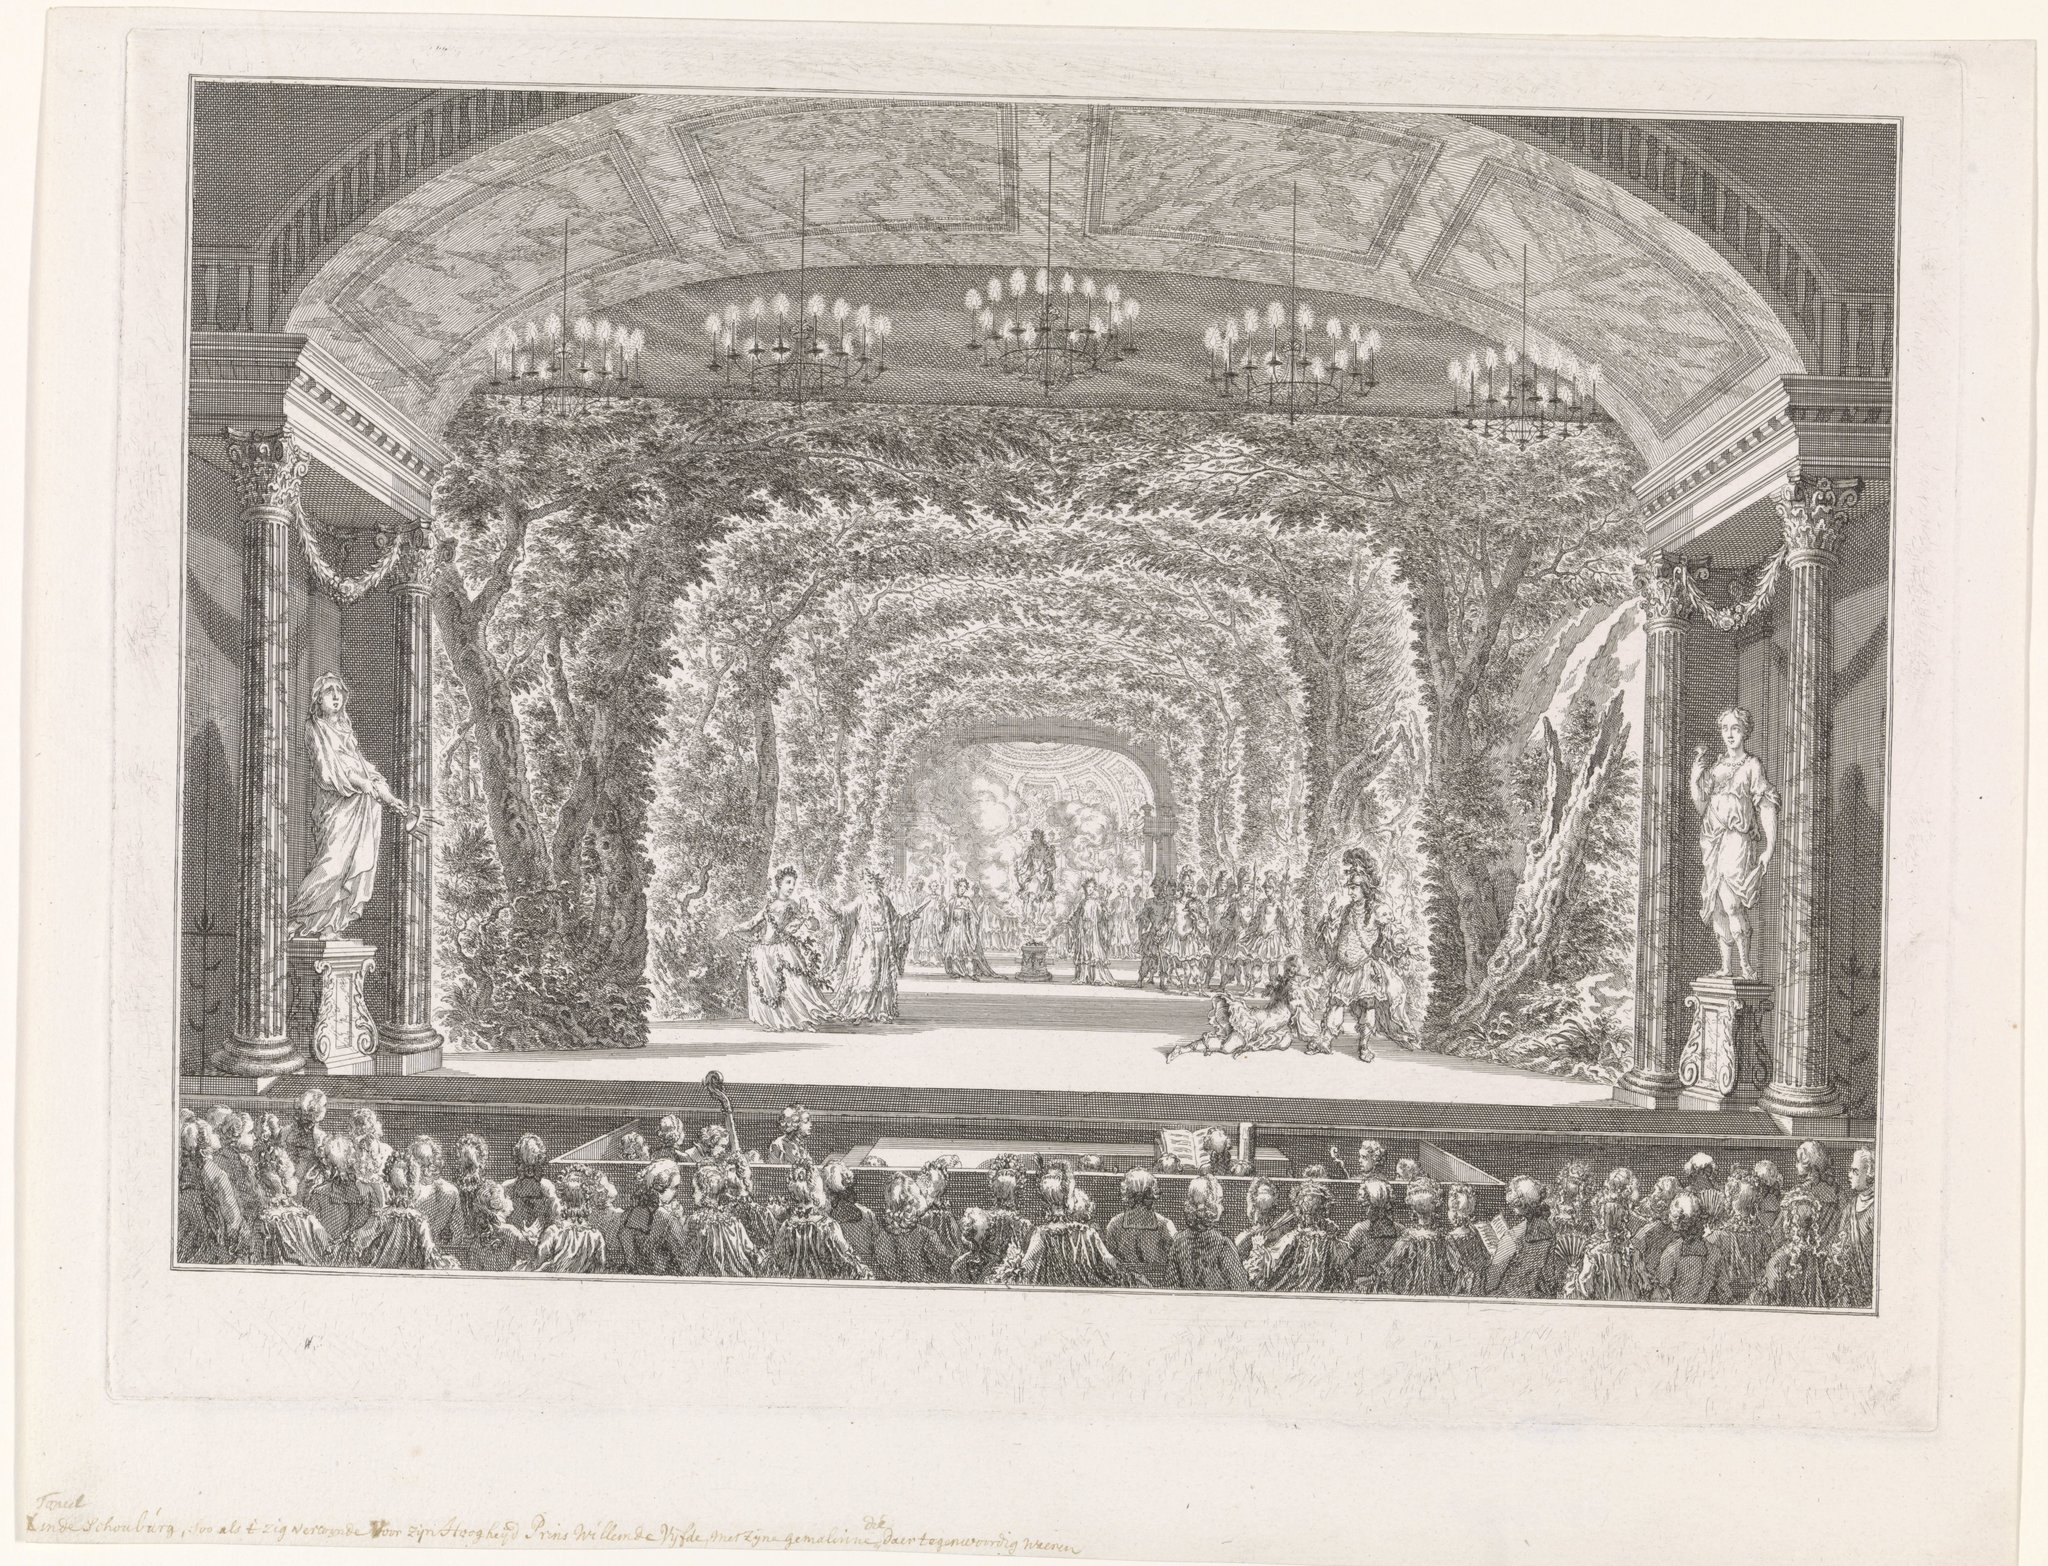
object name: print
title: Toneelvoorstelling in de Amsterdamse Schouwburg voor het prinselijk paar, 1768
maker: simon fokke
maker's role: draughtsman, print maker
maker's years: 1712-1784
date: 1769-1773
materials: paper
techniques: etching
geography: northern netherlands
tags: the hague, william v (prince of orange), berlin, painter, draughtsman, wilhelmina of prussia (princess of orange), public festivities on the occasion of royal events, theatre, theatrical performance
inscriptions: collector's mark: Lugt 2228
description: Toneelvoorstelling van het treurspel Demophontes voor de stadhouder Willem V en prinses Wilhelmina van Pruisen in de nieuwe Amsterdamse Schouwburg aan de Keizersgracht, 1 juni 1768. Onderdeel van een prentserie met titelprent en 14 platen van de inhaling van de prins en prinses te Amsterdam, 30 mei - 4 juni 1768.